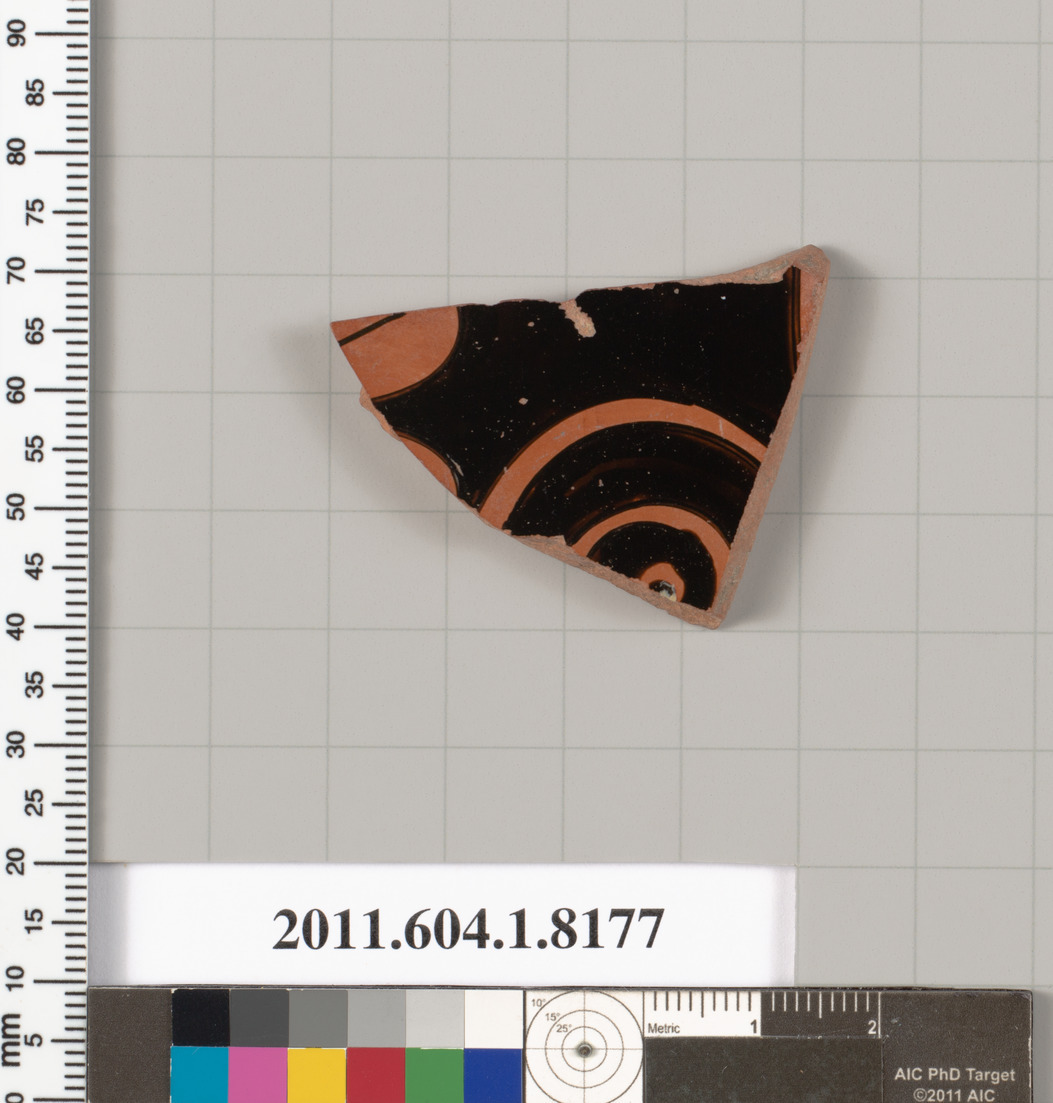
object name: kylix fragment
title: Terracotta fragment of a kylix (drinking cup)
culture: greek, attic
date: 520-510 BCE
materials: terracotta